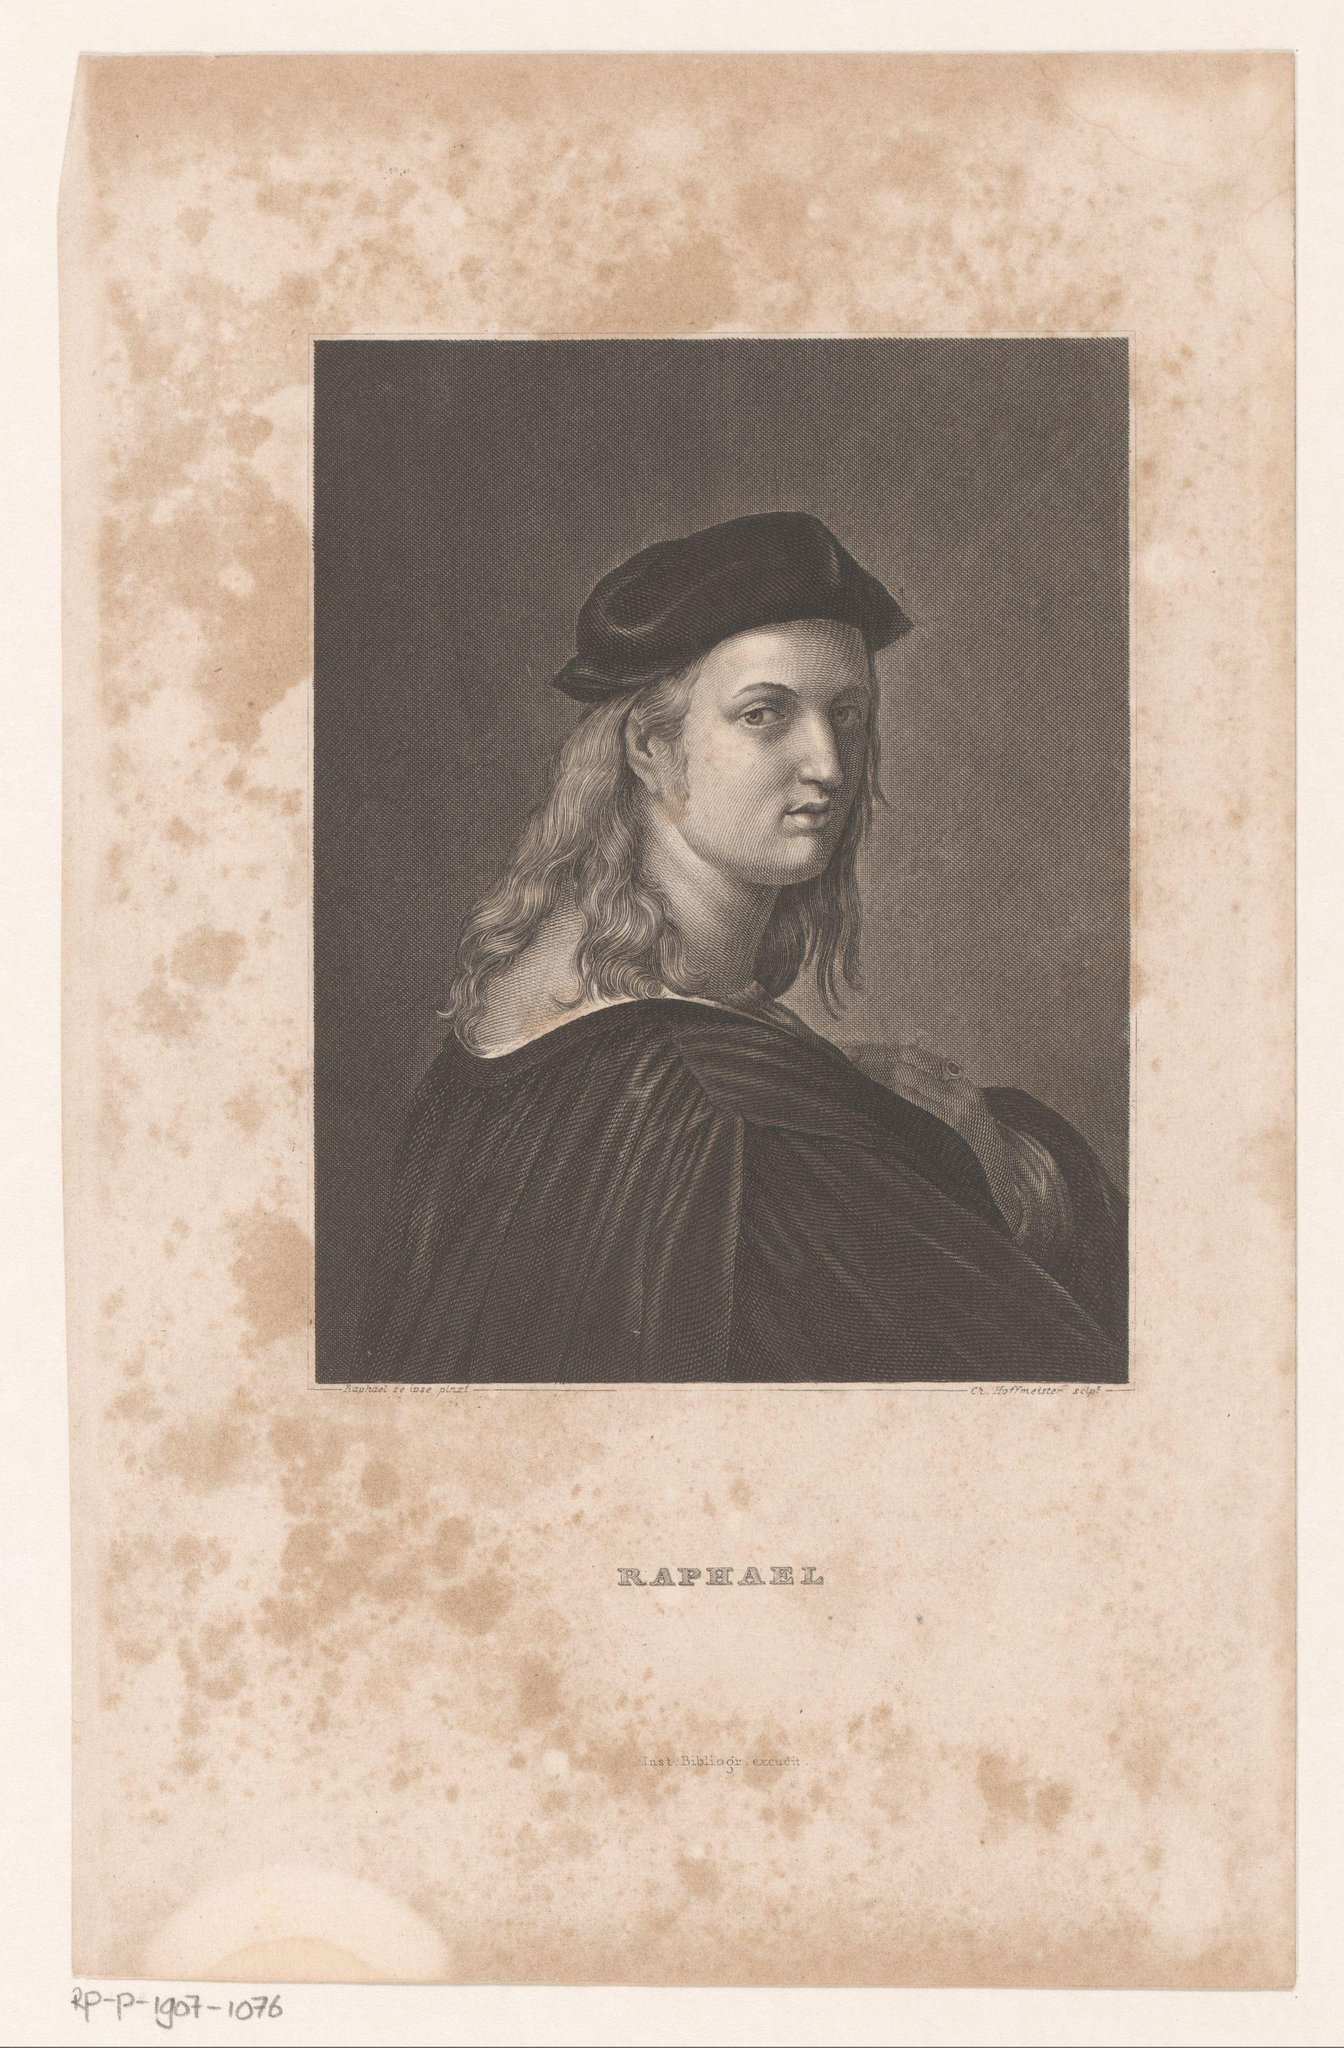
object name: print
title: Portret van Rafaël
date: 1828-1871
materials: paper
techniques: engraving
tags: rome, painter, rafaël, historical persons, portrait, self-portrait of painter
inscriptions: collector's mark: Lugt 2228